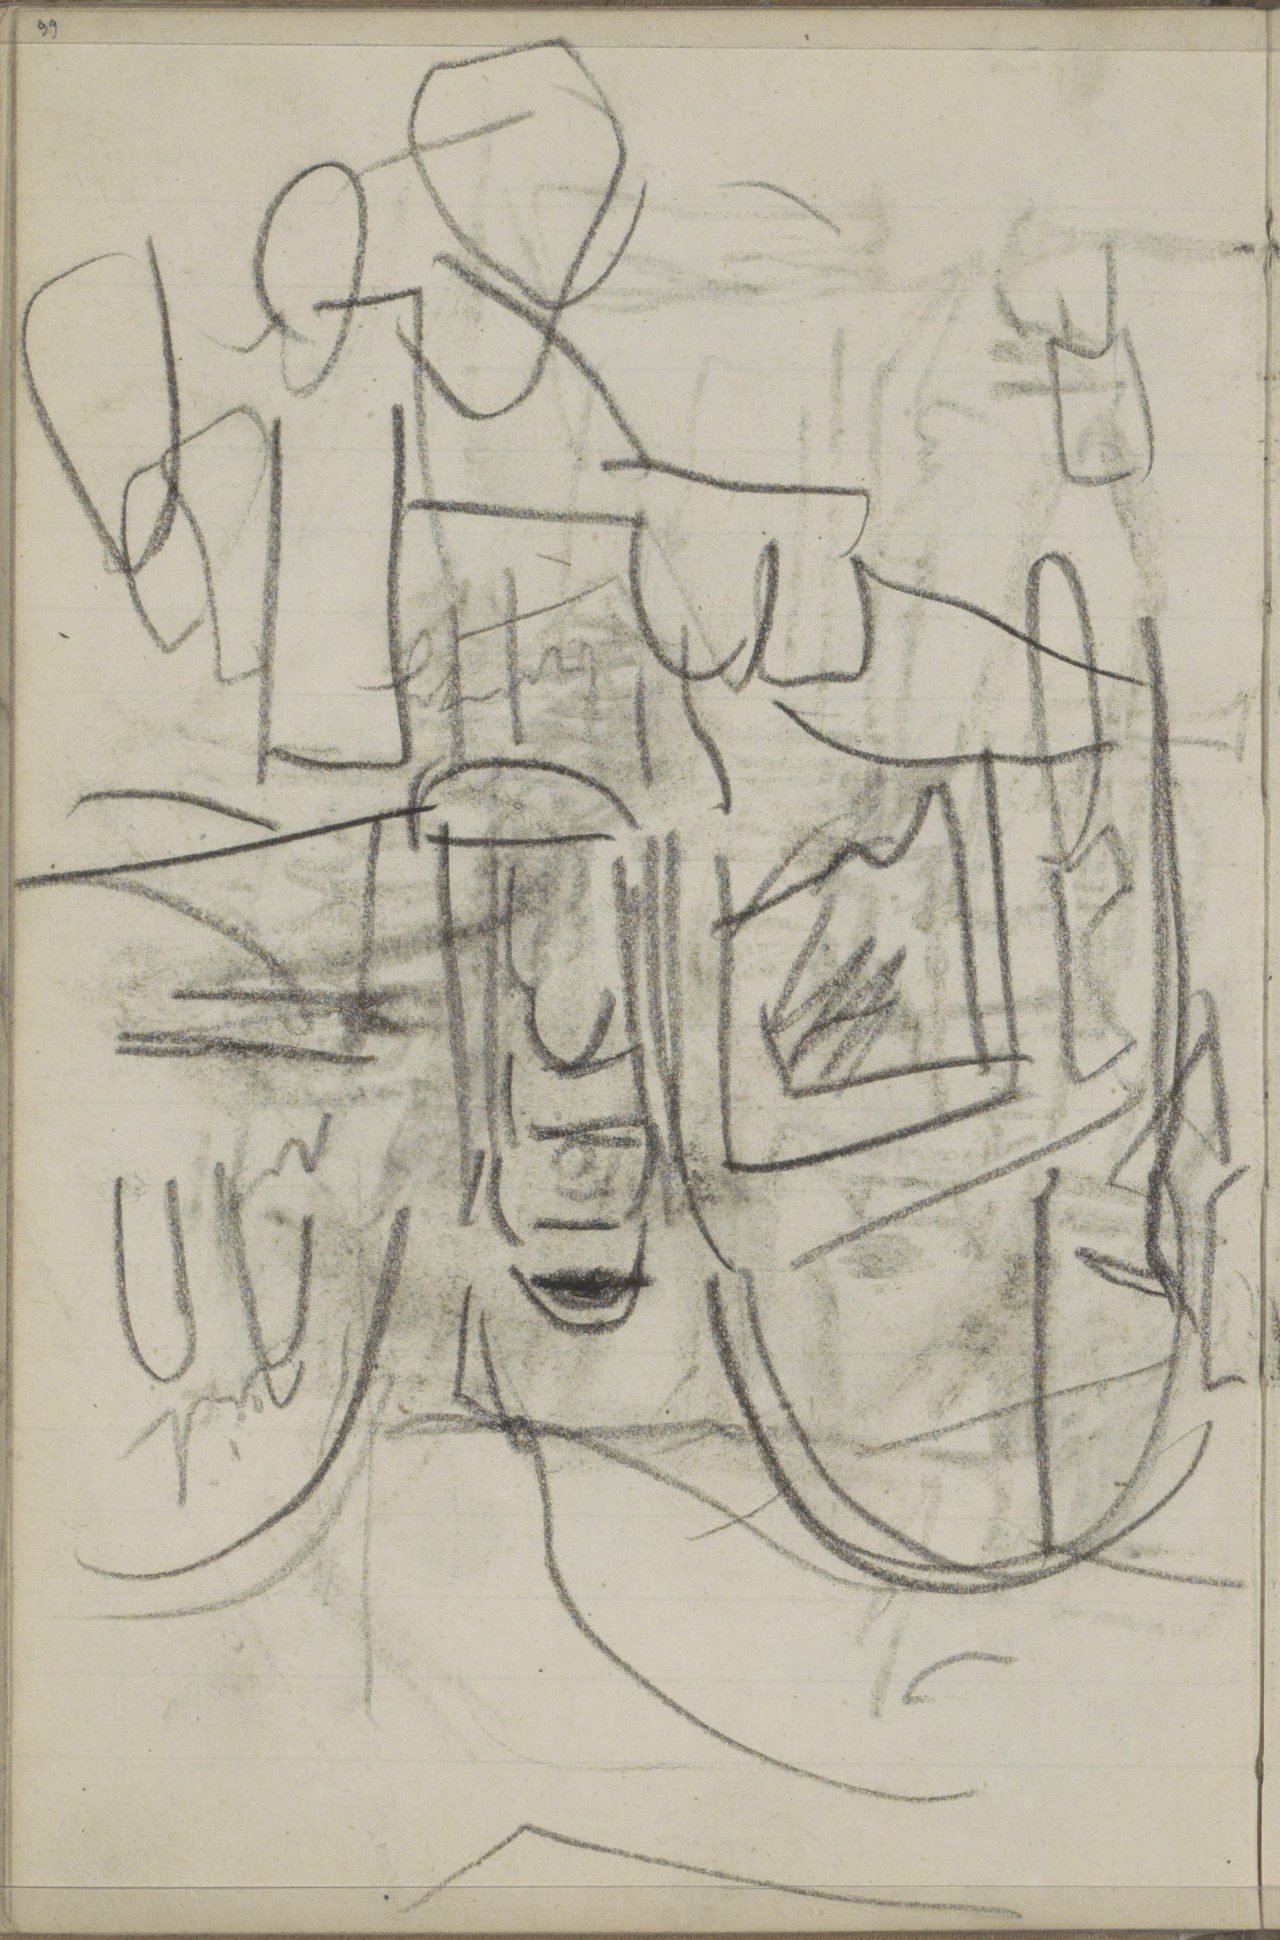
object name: sketchbook leaf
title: Architectuurstudie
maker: marius bauer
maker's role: draughtsman, print maker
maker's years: 1867-1932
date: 1888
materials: chalk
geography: istanbul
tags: architecture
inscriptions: kleurnotitie, handgeschreven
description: Met onder andere rondbogen. Pagina 99 uit een schetsboek met 56 bladen.